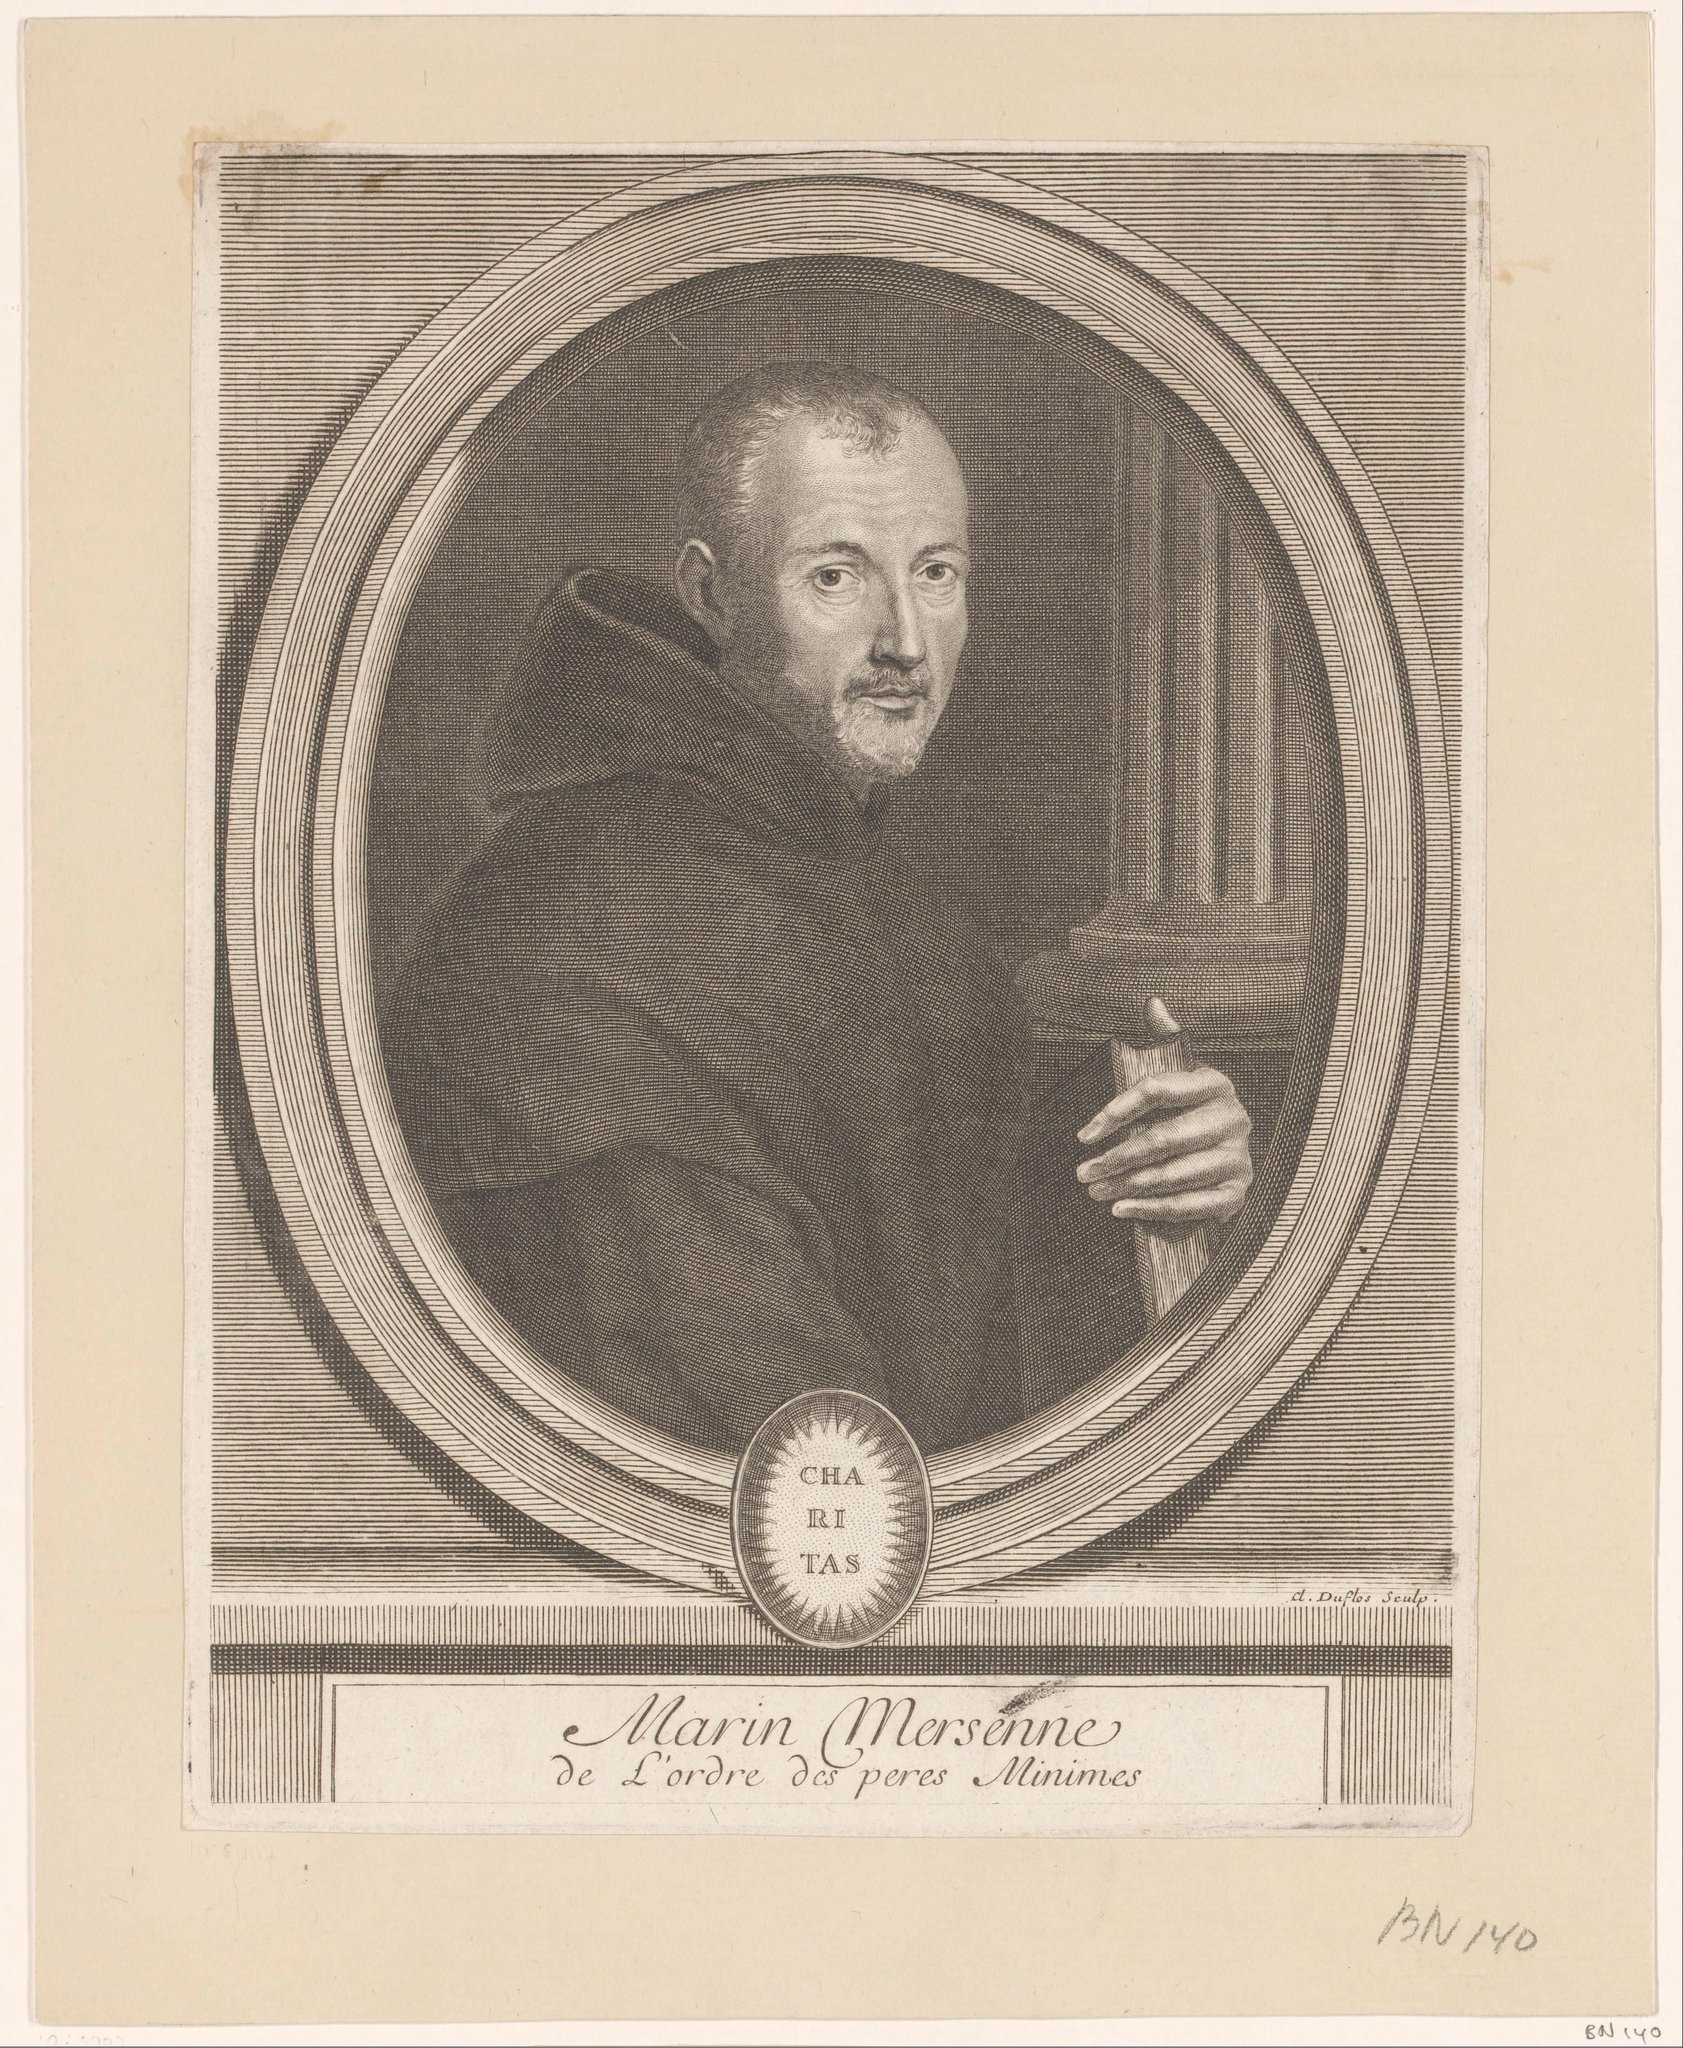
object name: print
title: Marin Mersenne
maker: claude duflos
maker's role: print maker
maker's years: 1665-1727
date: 1675-1727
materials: paper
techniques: engraving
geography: france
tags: paris, ornament ~ medallion, historical persons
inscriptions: collector's mark: Lugt 2228